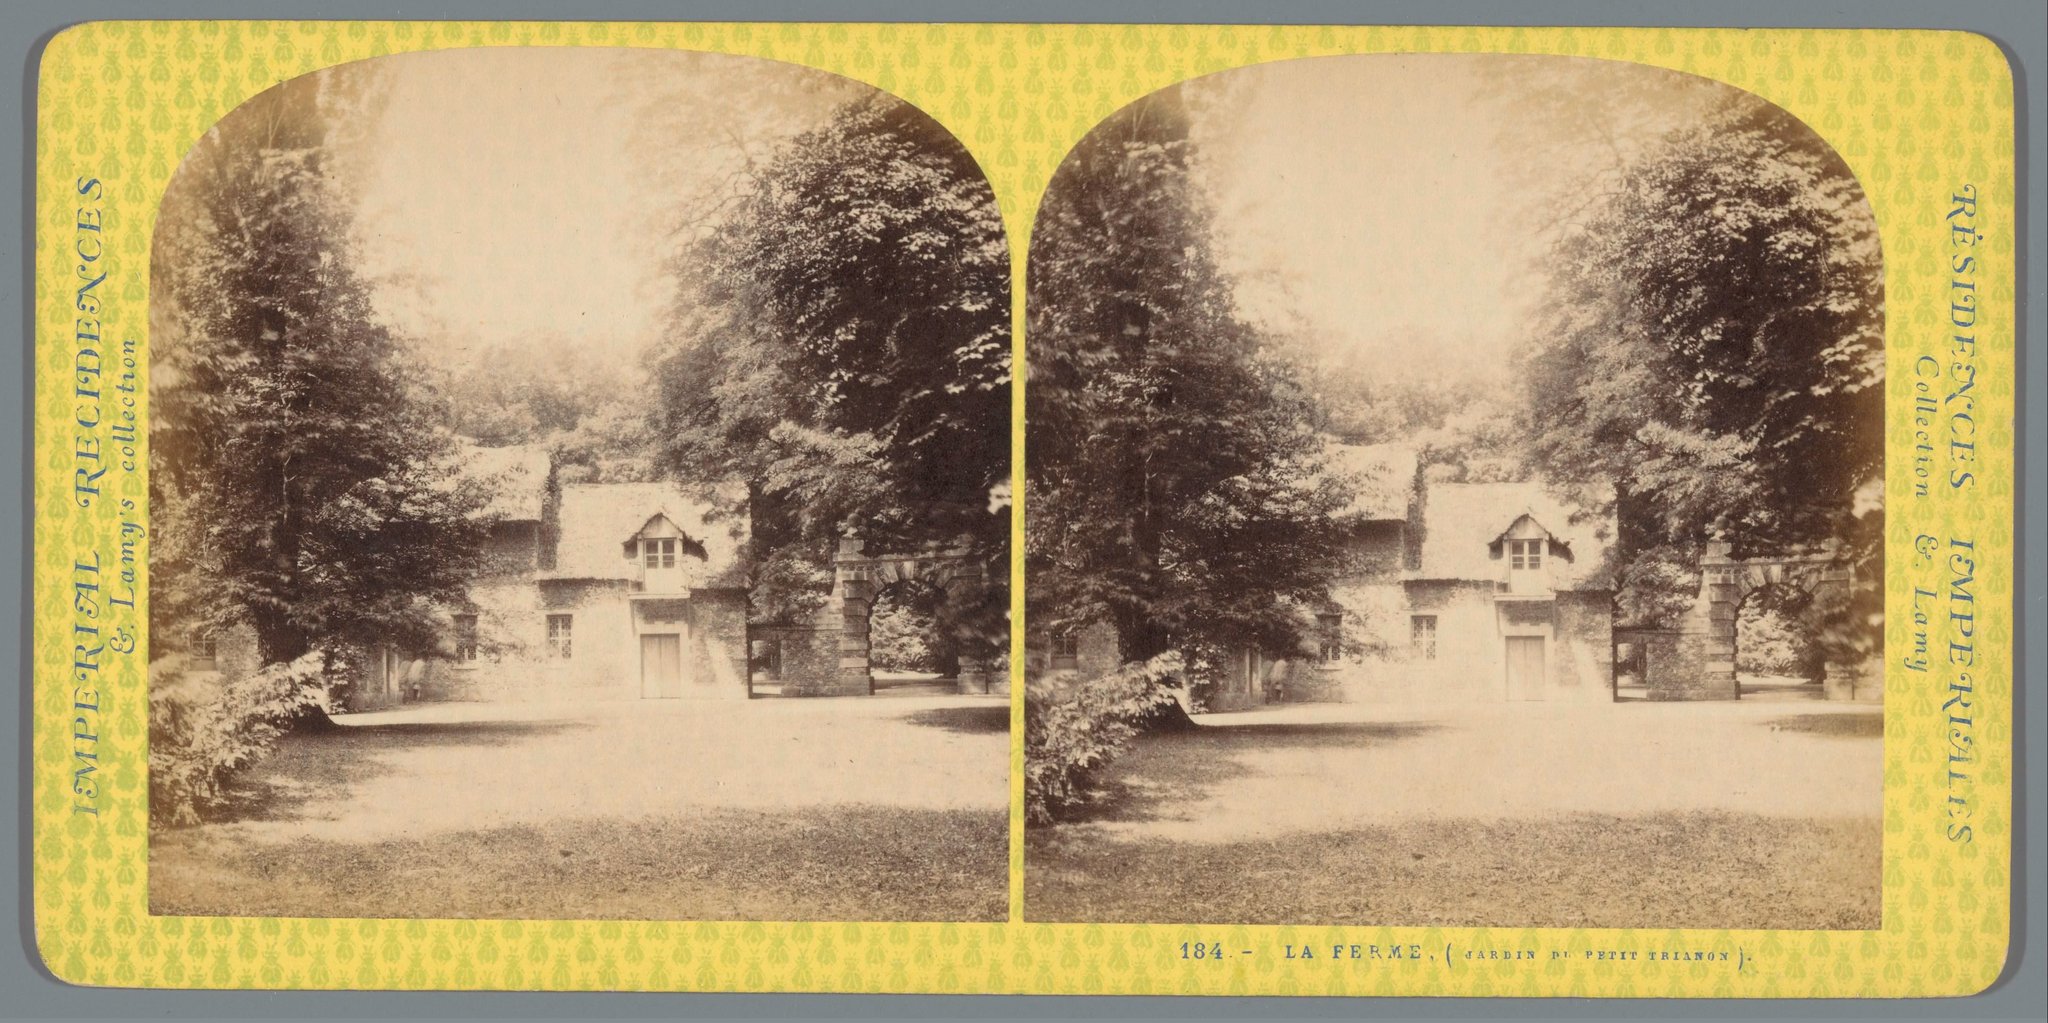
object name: stereograph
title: La Ferme, (Jardin du Petit Trianon)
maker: ernest eléonor pierre lamy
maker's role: publisher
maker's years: 1828-1900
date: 1860-1880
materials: cardboard, photographic support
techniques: albumen print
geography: le hameau de la reine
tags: garden, farm (building)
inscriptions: number: ‘184.’, inscription: ‘E. Lamy's collection’